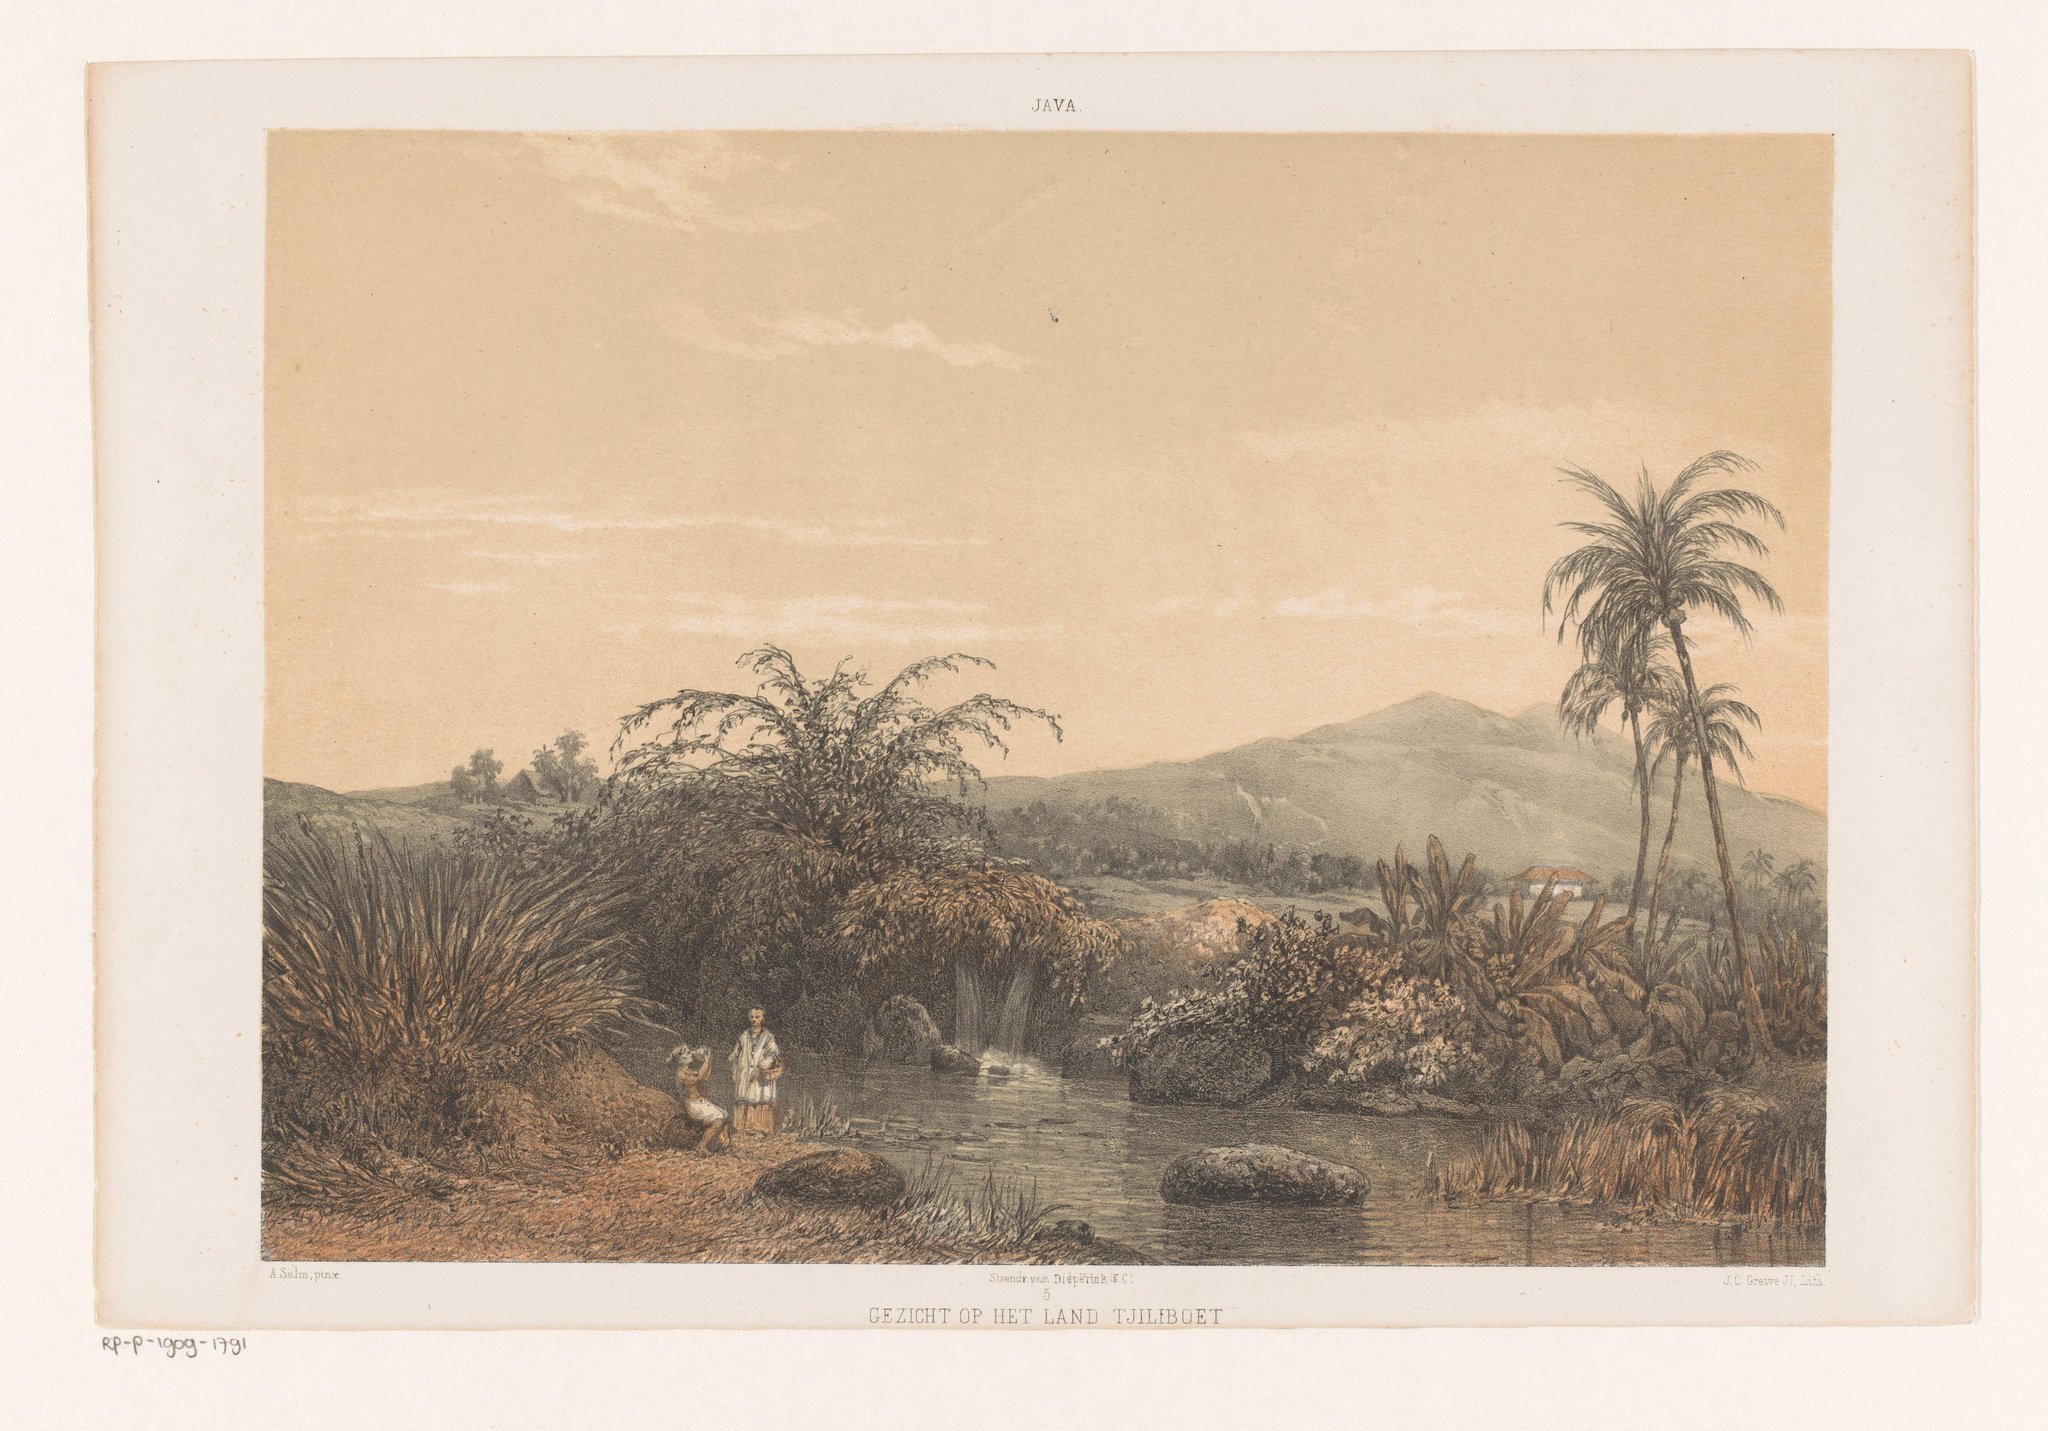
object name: print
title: Gezicht op Tjileboet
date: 1874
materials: paper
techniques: tone lithography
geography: java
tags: waterfall, landscapes (+ landscape with figures, staffage), river (+ landscape with figures, staffage), java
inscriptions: collector's mark: Lugt 2228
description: In een landschap bij een rivier met een kleine waterval staan twee figuren. Een van hen drinkt uit een kruik.